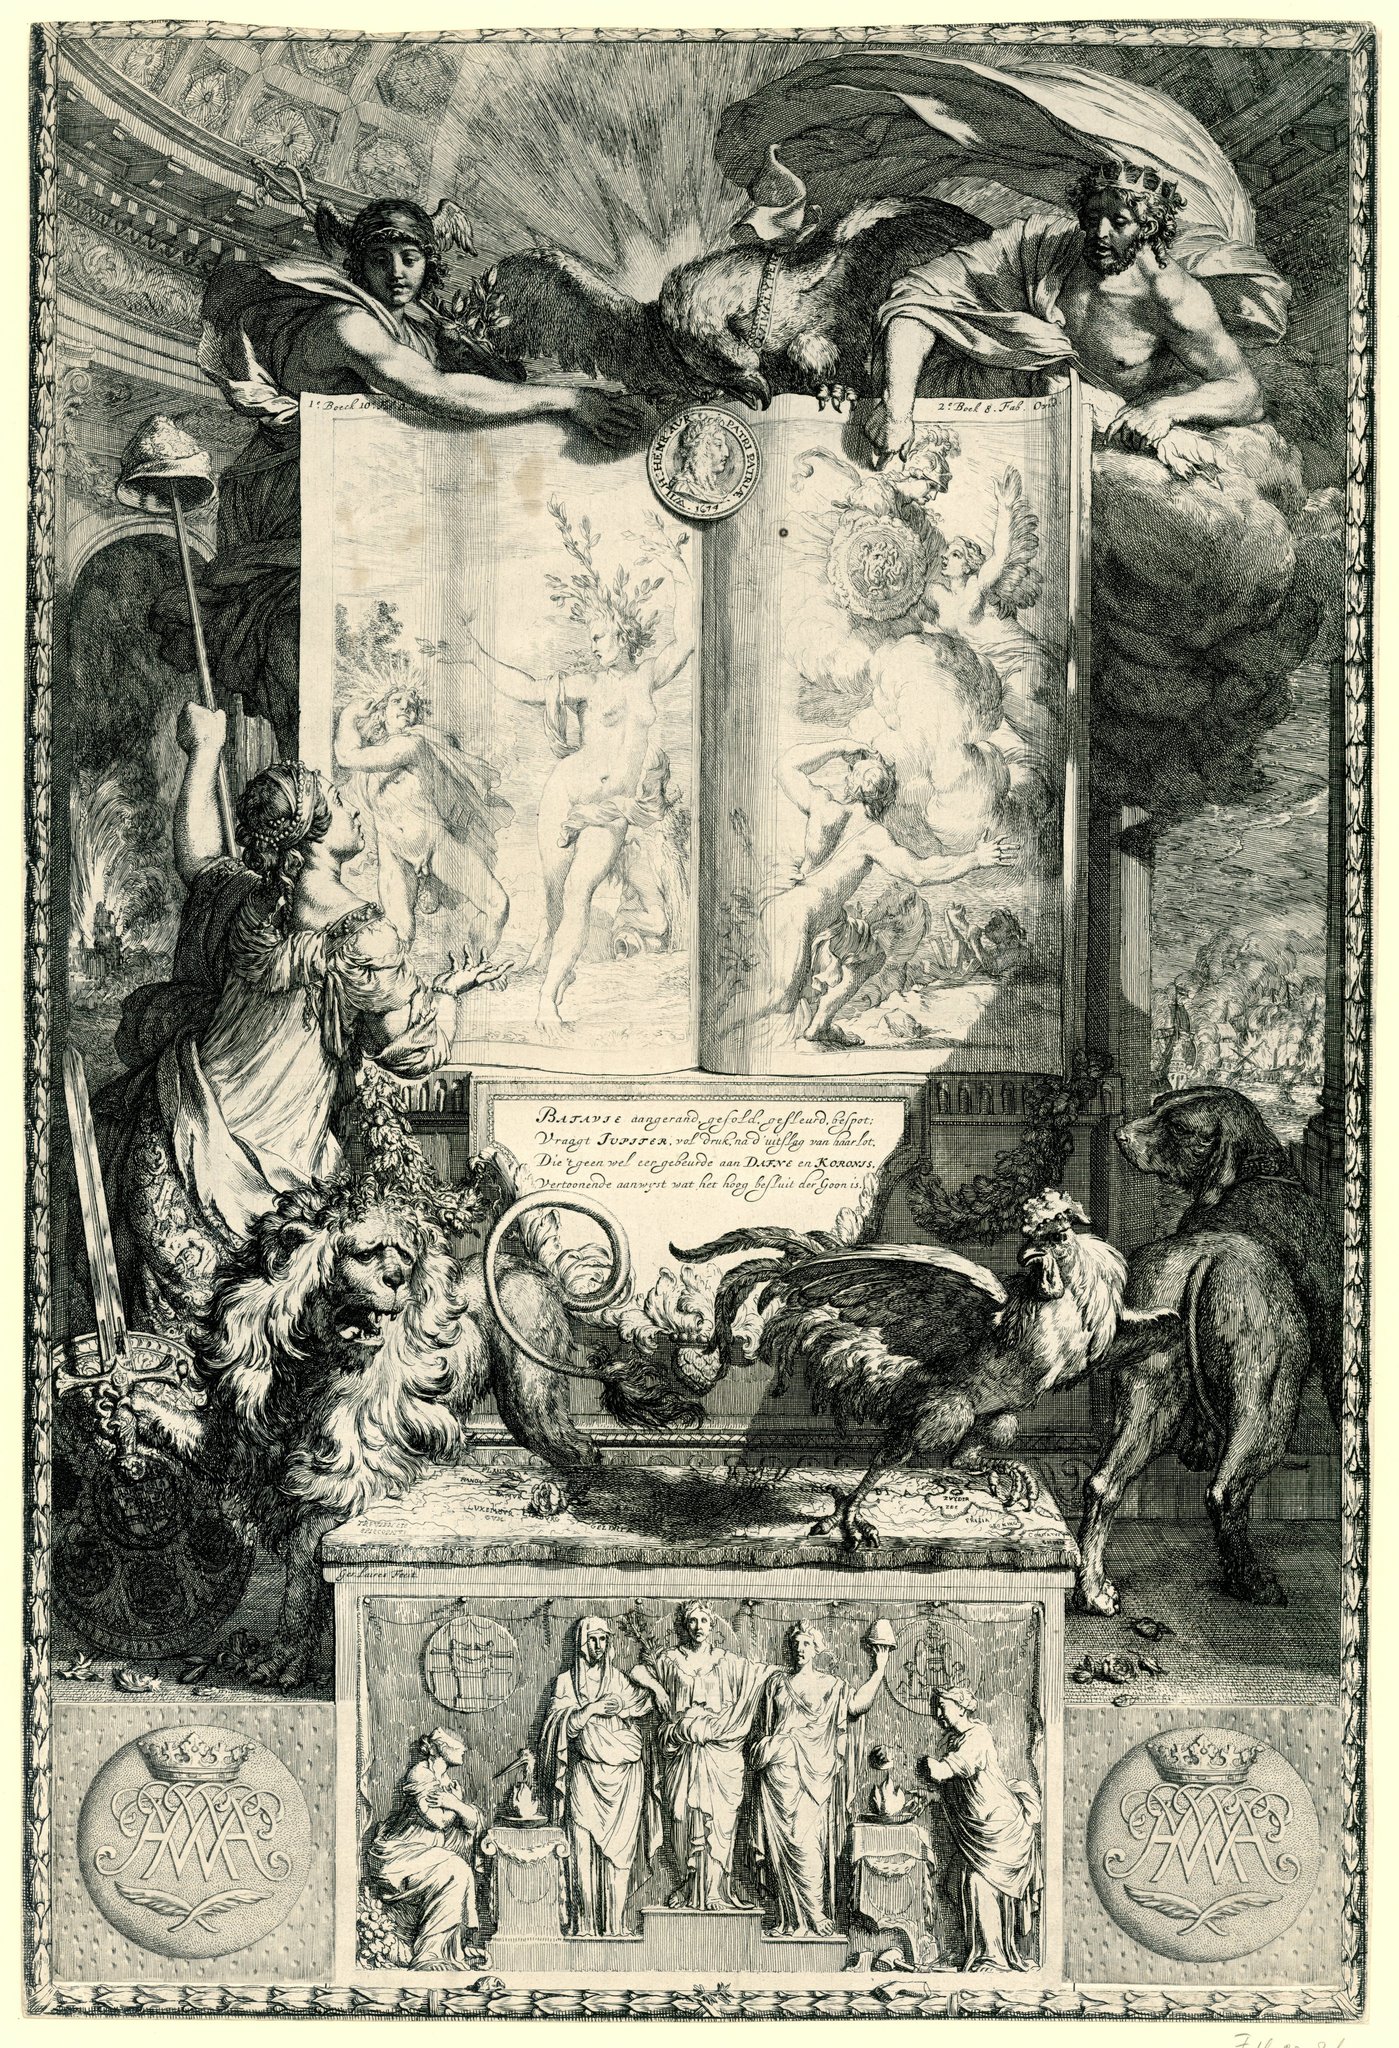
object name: print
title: Zinneprent op de overwinning van Nederland onder het leiderschap van Willem III, 1674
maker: gerard de lairesse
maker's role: draughtsman, painter, print maker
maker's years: 1641-1711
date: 1674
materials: paper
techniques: etching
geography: northern netherlands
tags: the hague, william iii (prince of orange and king of england, scotland, and ireland), coronis changed into a crow: to escape the love of neptune, coronis, daughter of coroneus, is changed into a crow by minerva (ovid, metamorphoses ii 569), daphne changed into a laurel-tree: while fleeing from apollo, daphne is changed into a laurel-tree by her father peneus (ovid, metamorphoses i 548)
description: Grote allegorische voorstelling op de overwinning van de Republiek onder het leiderschap van Willem III in 1674. Door middel van twee verhalen uit de Griekse mythologie wordt de overwinning van de Verenigde Nederlanden onder het leiderschap van prins Willem op haar vijanden, vastgelegd in de Vrede van Westminster op 19 februari 1674, verheerlijkt. Mercurius en Jupiter wijzen de Nederlandse Maagd met de vrijheidshoed op een openstaand boek van de Metamorphosen van Ovidius waarin scènes uit de verhalen van Apollo en Daphne en Neptunus en Coronis te zien zijn. Hieronder de Nederlandse Leeuw die de Franse haan en een Engelse hond verjaagt. Onderaan worden links en rechts de fabelen en de politieke interpretatie uitgelegd. Bij dit exemplaar van de prent zijn over de twee verzen (onderaan links en rechts en waarin de fabelen en de politieke interpretatie worden uitgelegd) bladen met het monogram WH van Willem III geplakt.